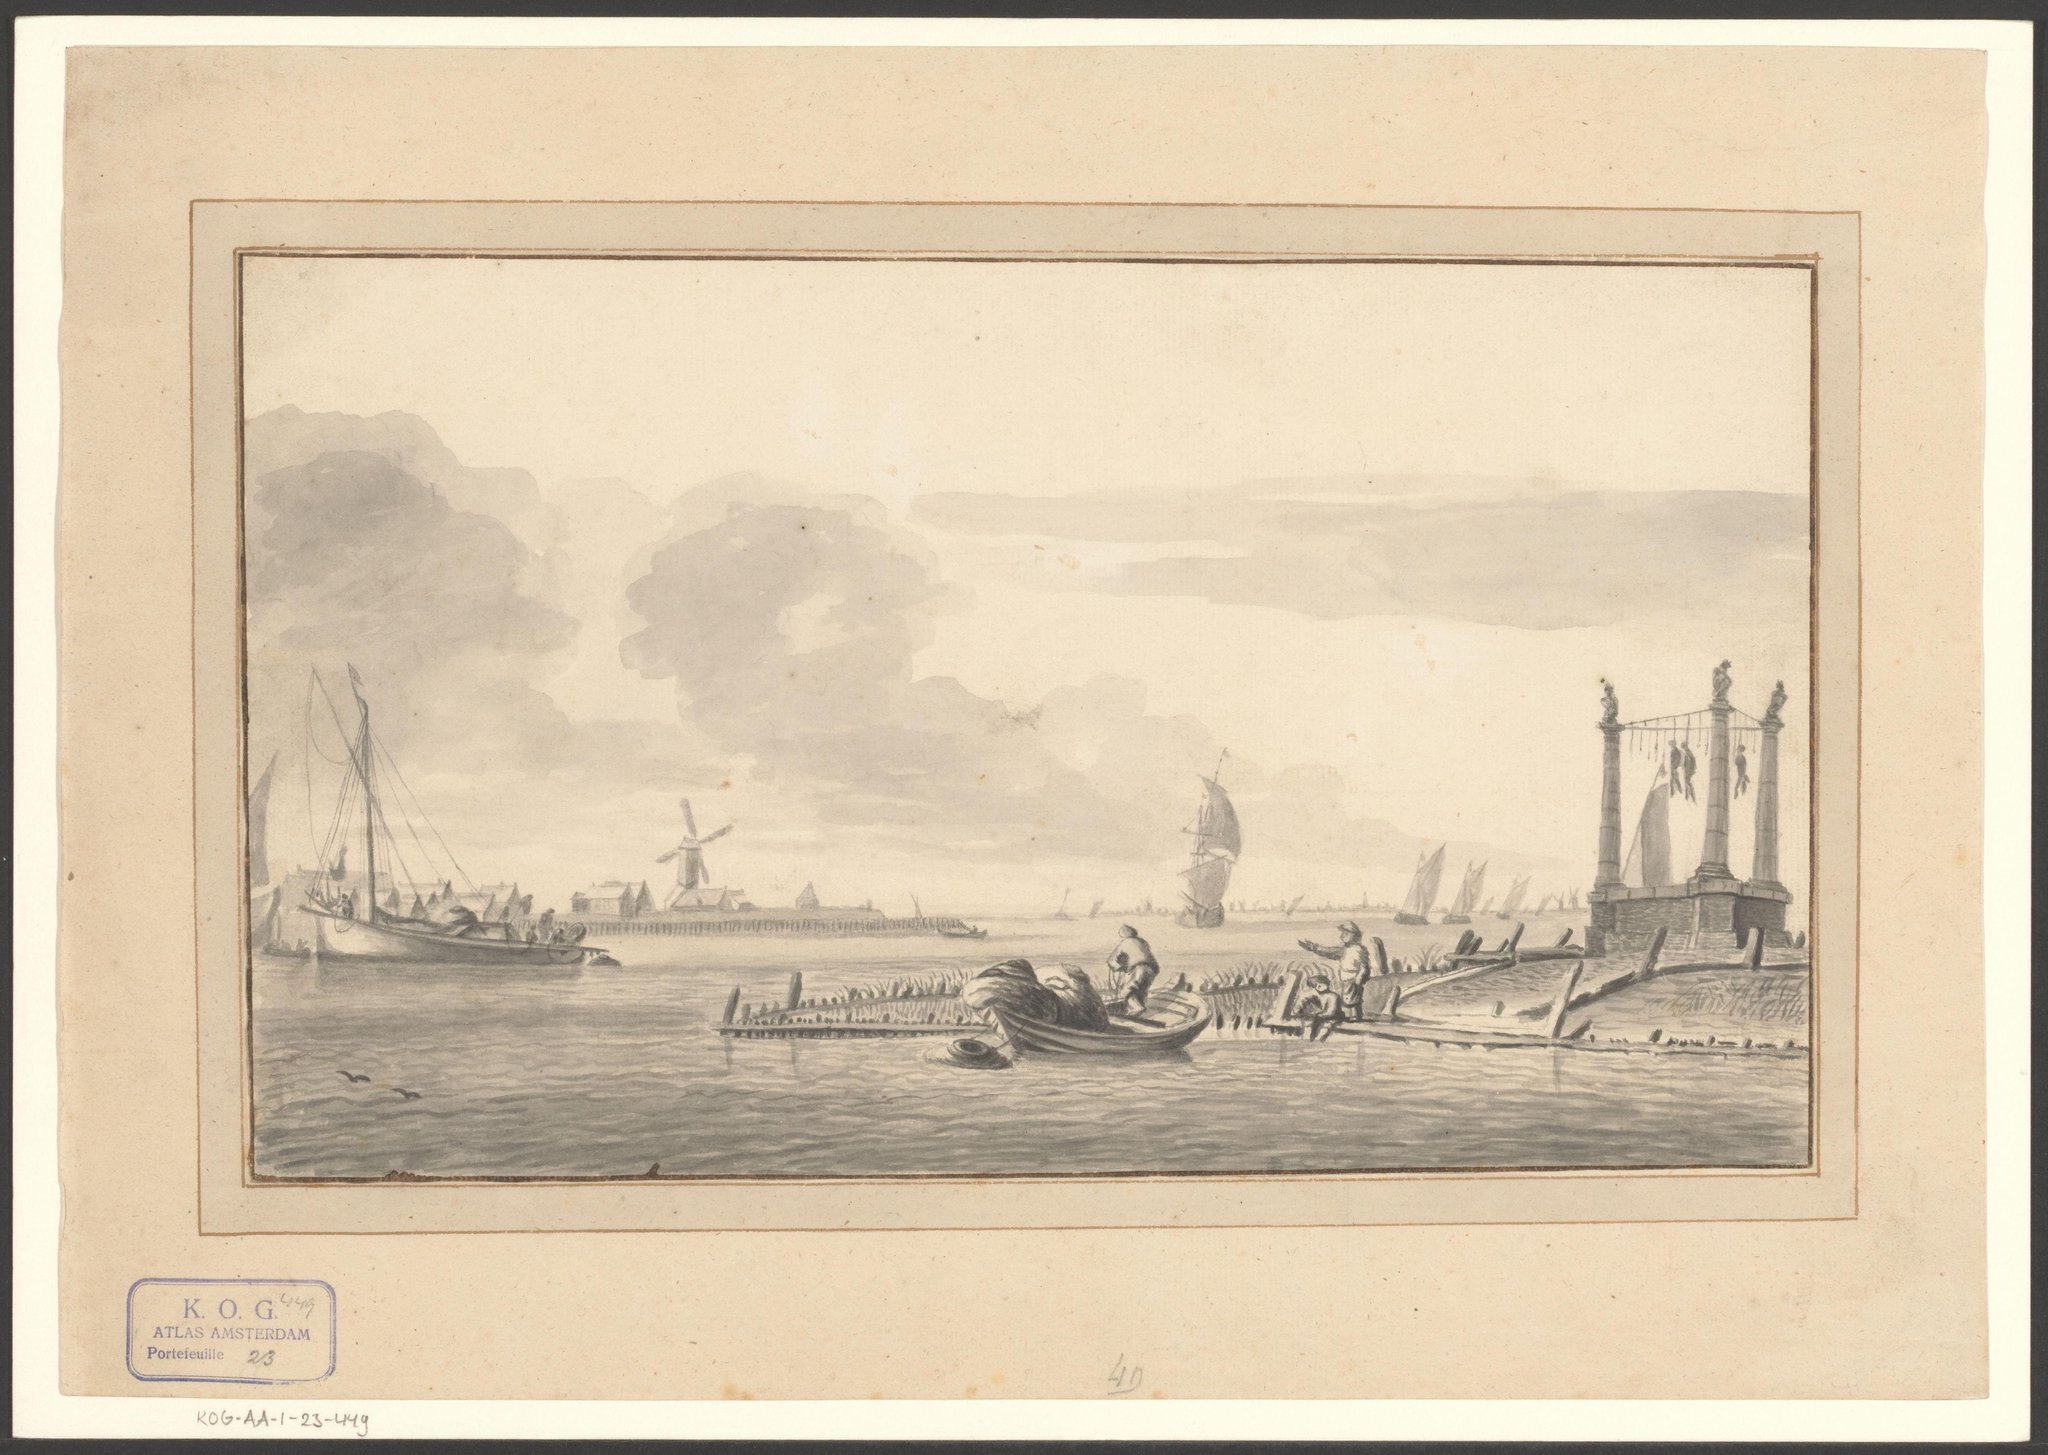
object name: drawing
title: Gezicht op het galgenveld bij Volewijk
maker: Anonymous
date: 1650-1699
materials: ink, paper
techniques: brush, pen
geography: amsterdam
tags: instruments of torture, execution or punishment: gallows, city-view in general; 'veduta', river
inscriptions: collector's mark: ‘23’ Lugt 1641b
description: Onderwerpsrubriek binnen de Atlas Amsterdam: Handvesten, Keuren, enz.; Rechtswezen (incl. gevangenissen, enz.).